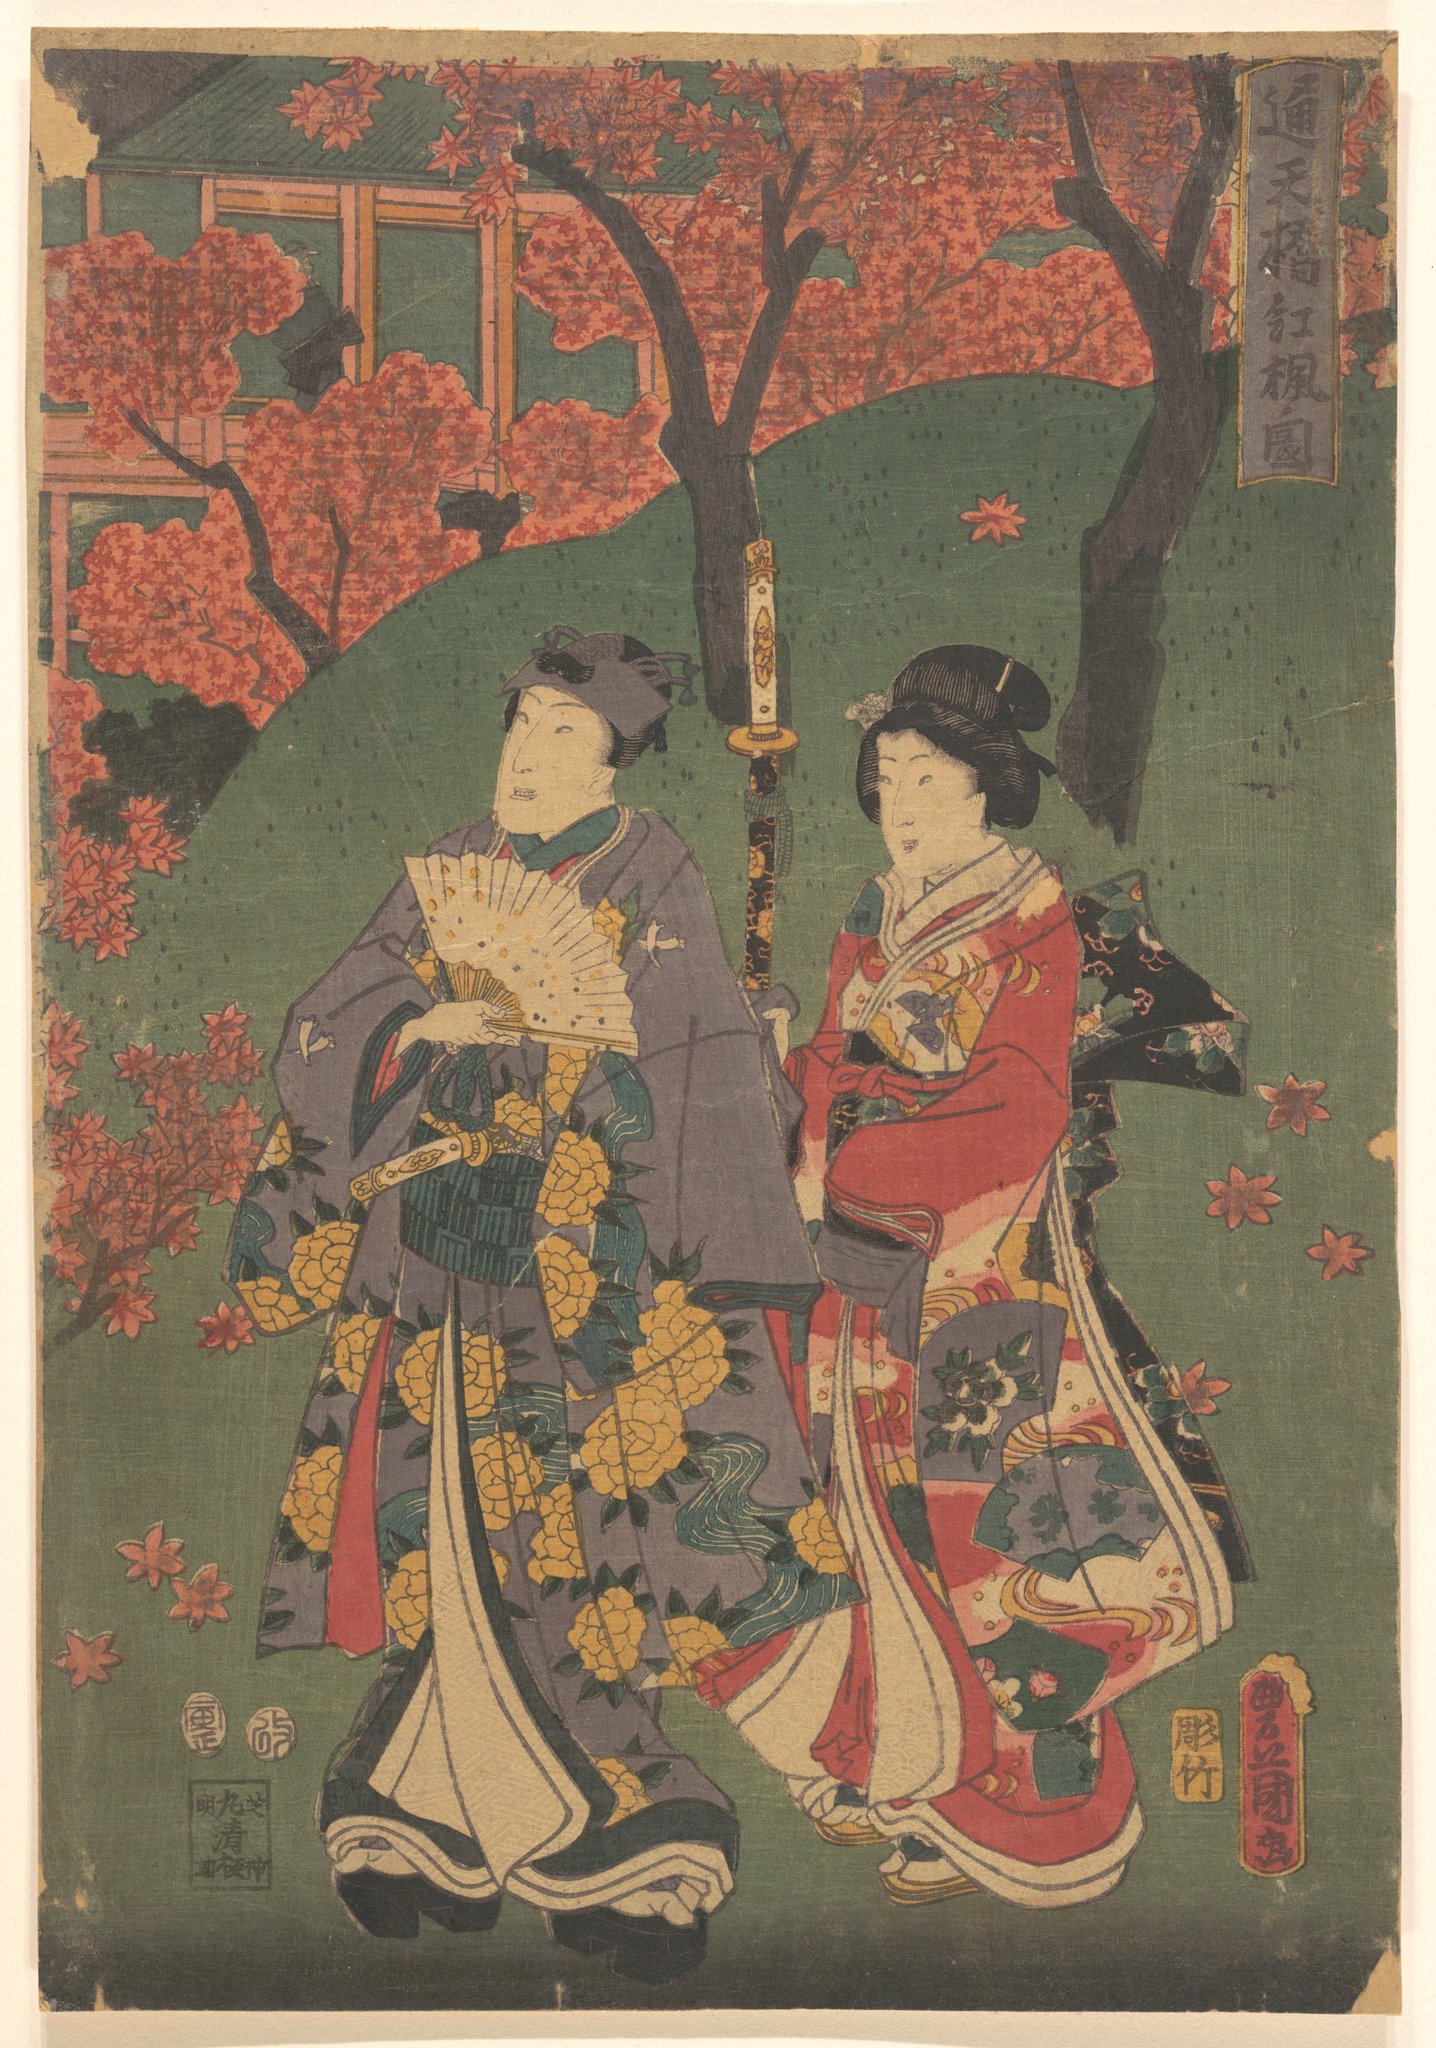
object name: print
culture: japanese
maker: utagawa kunisada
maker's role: artist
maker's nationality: japanese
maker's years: 1786-1864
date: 1786-1854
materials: ink, paper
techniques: woodblock print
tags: fans,women,trees